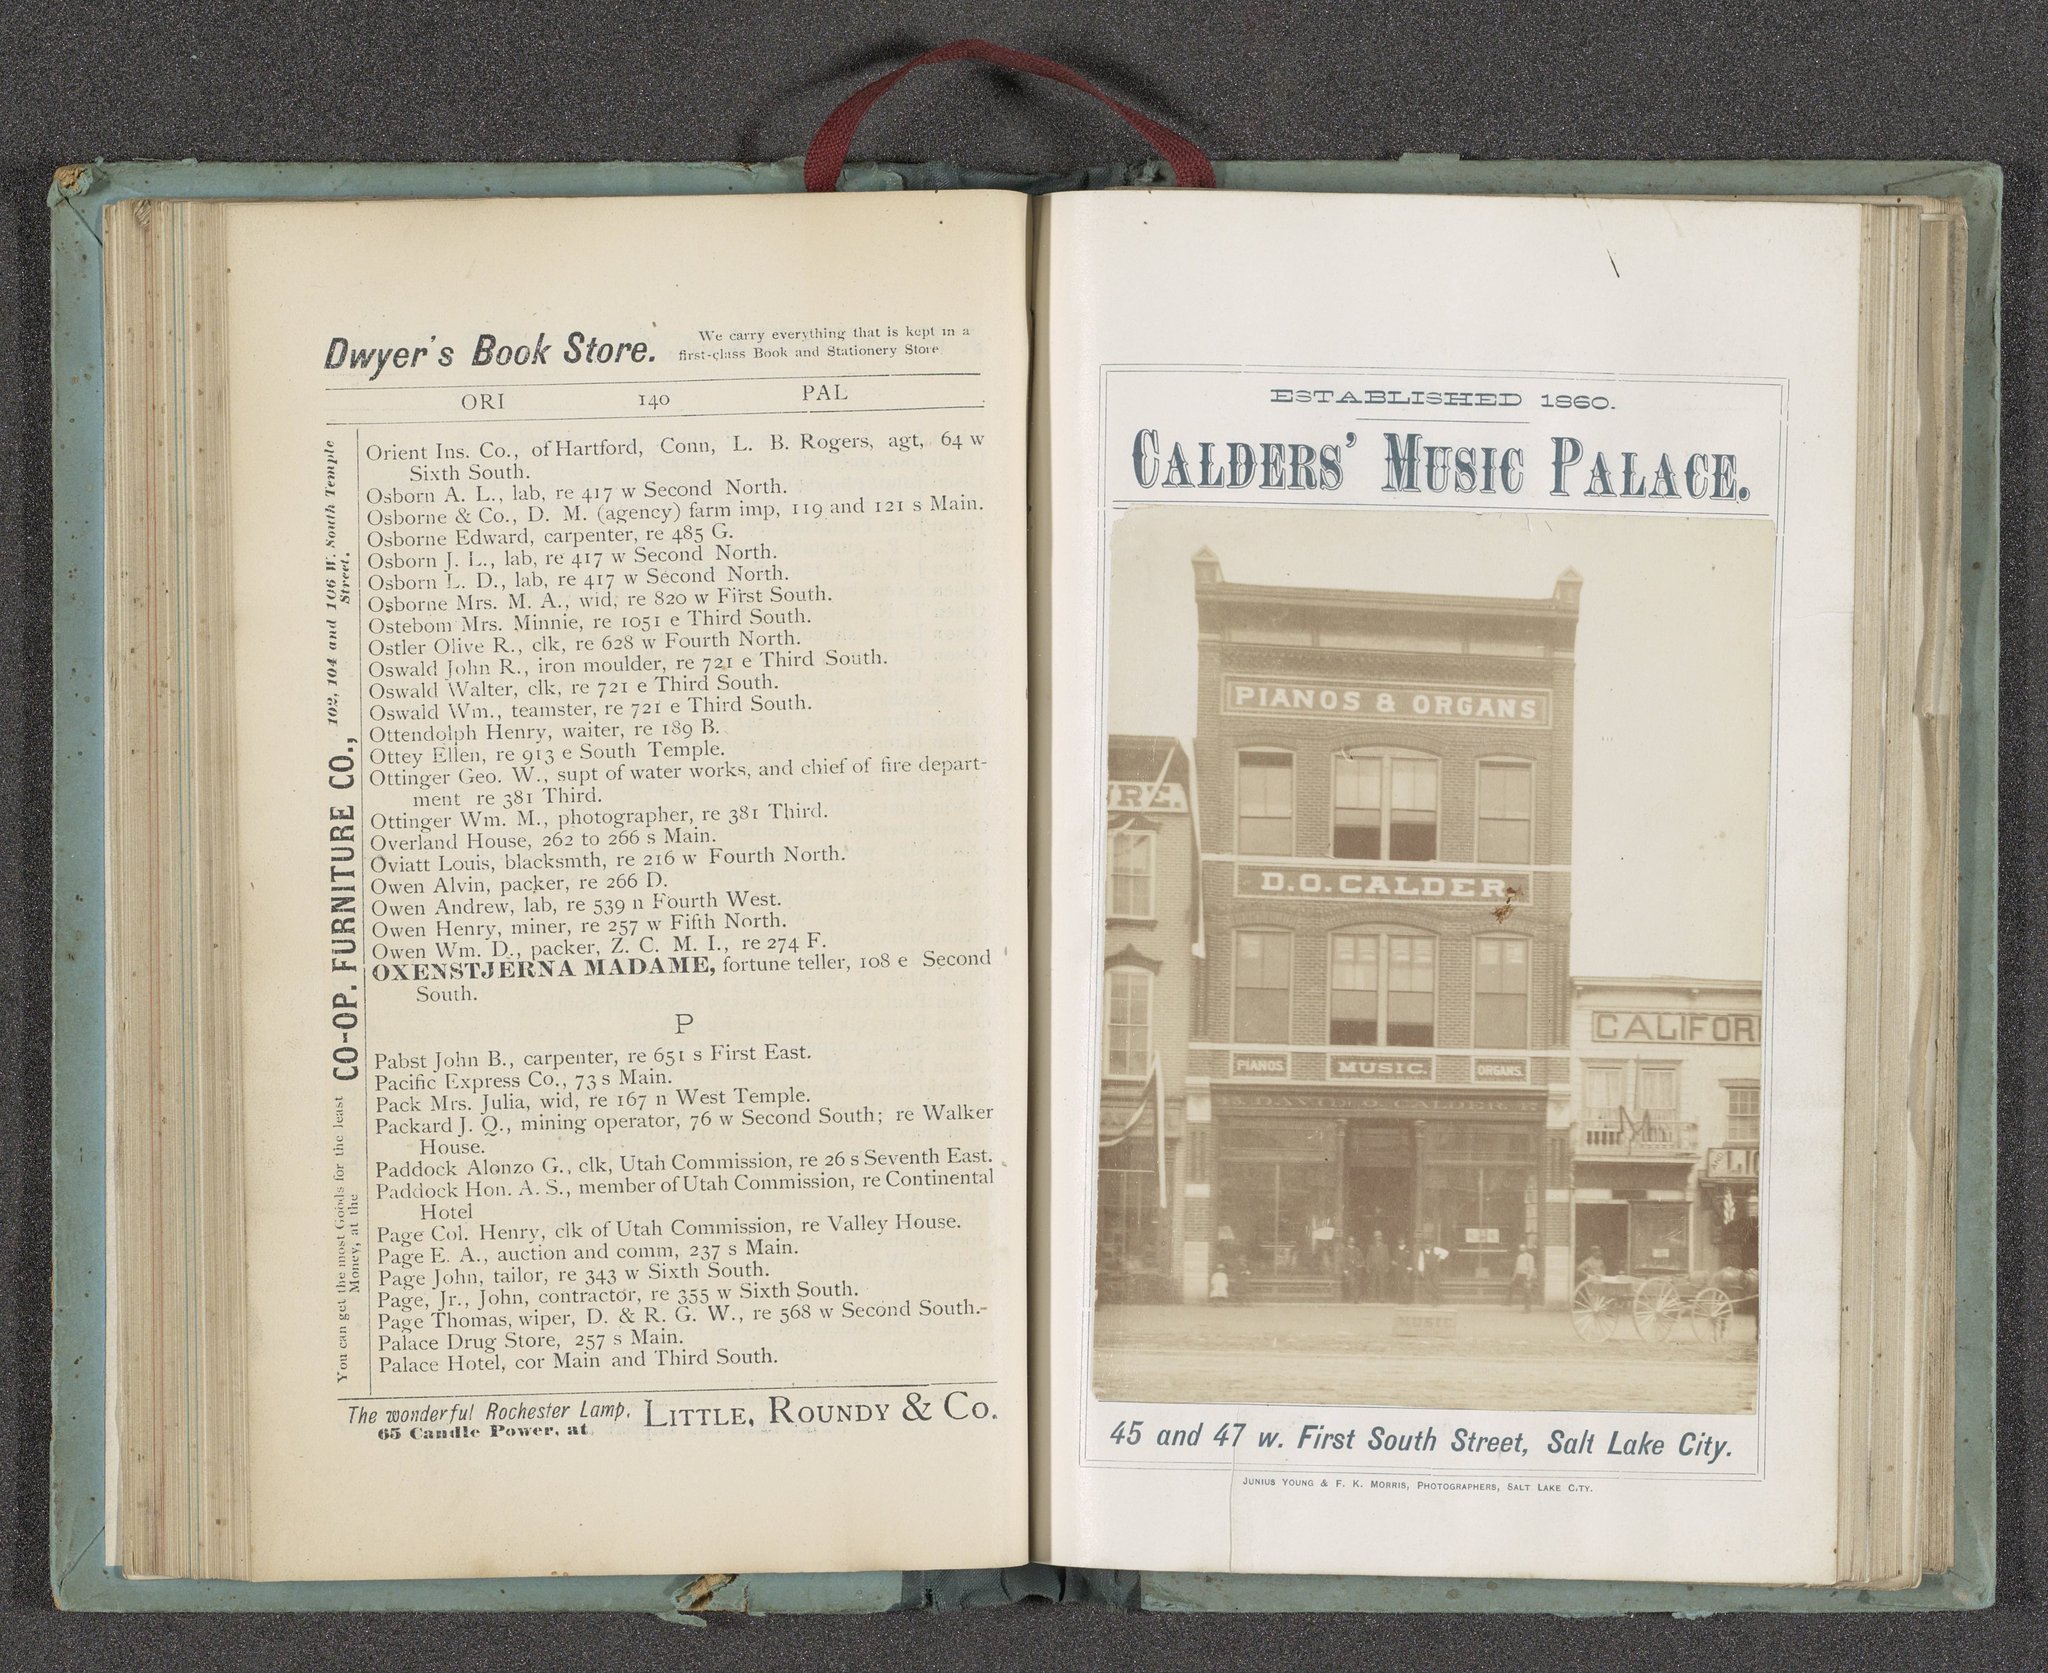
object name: photograph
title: Calders' Music Palace. 45 and 47 w. First South Street, Salt Lake City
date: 1875-1885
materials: photographic support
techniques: albumen print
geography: salt lake city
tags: shop, store, façade (of house or building), street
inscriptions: inscription: ‘Established 1860.’